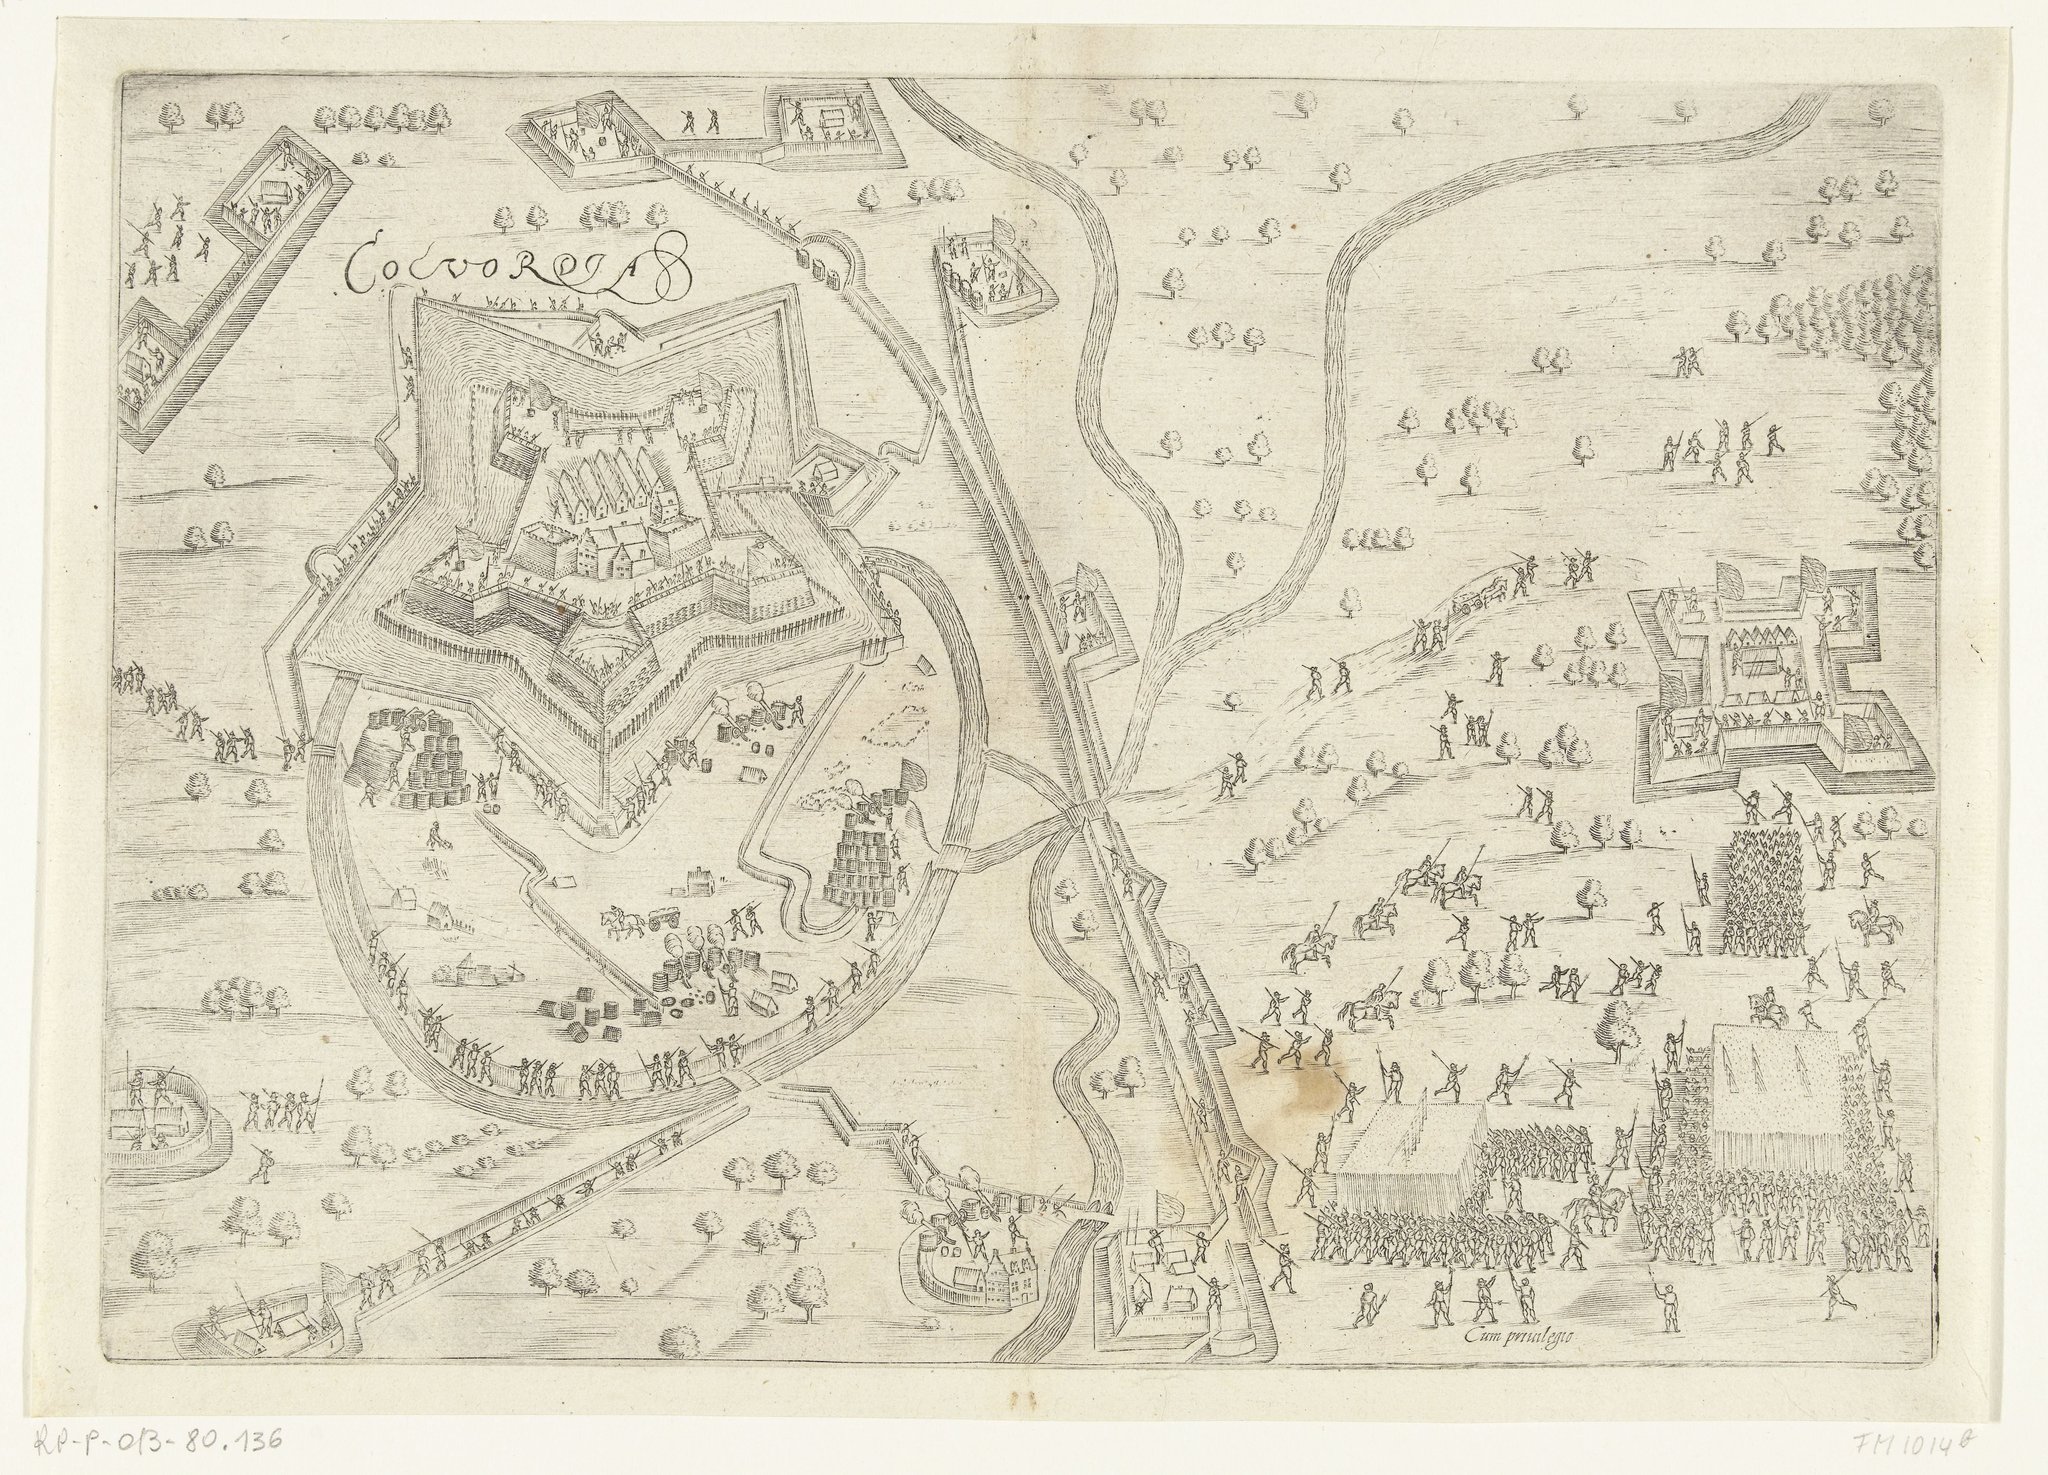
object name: history print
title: Beleg van Coevorden, 1592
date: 1600-1601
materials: paper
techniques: engraving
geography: northern netherlands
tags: the hague, maurice (prince of orange), siege, position war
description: Gebruikt als illustratie in: J.J. Orlers, De oorlochs-daden vanden doorlichtigen vorst Mavrits van Nassav. Of den nievven vermeerden Nassavschen lauren-crans: Warachtige beschrijvinghe van alle de belegeringhen ende victorien, te water ende te lande. Die God almachich[!], tot welvaren der Vereenichde Nederlanden te wege gebracht ende gegeven heeft, J.J. Orlers en H. van Haestens, Leiden 1619.